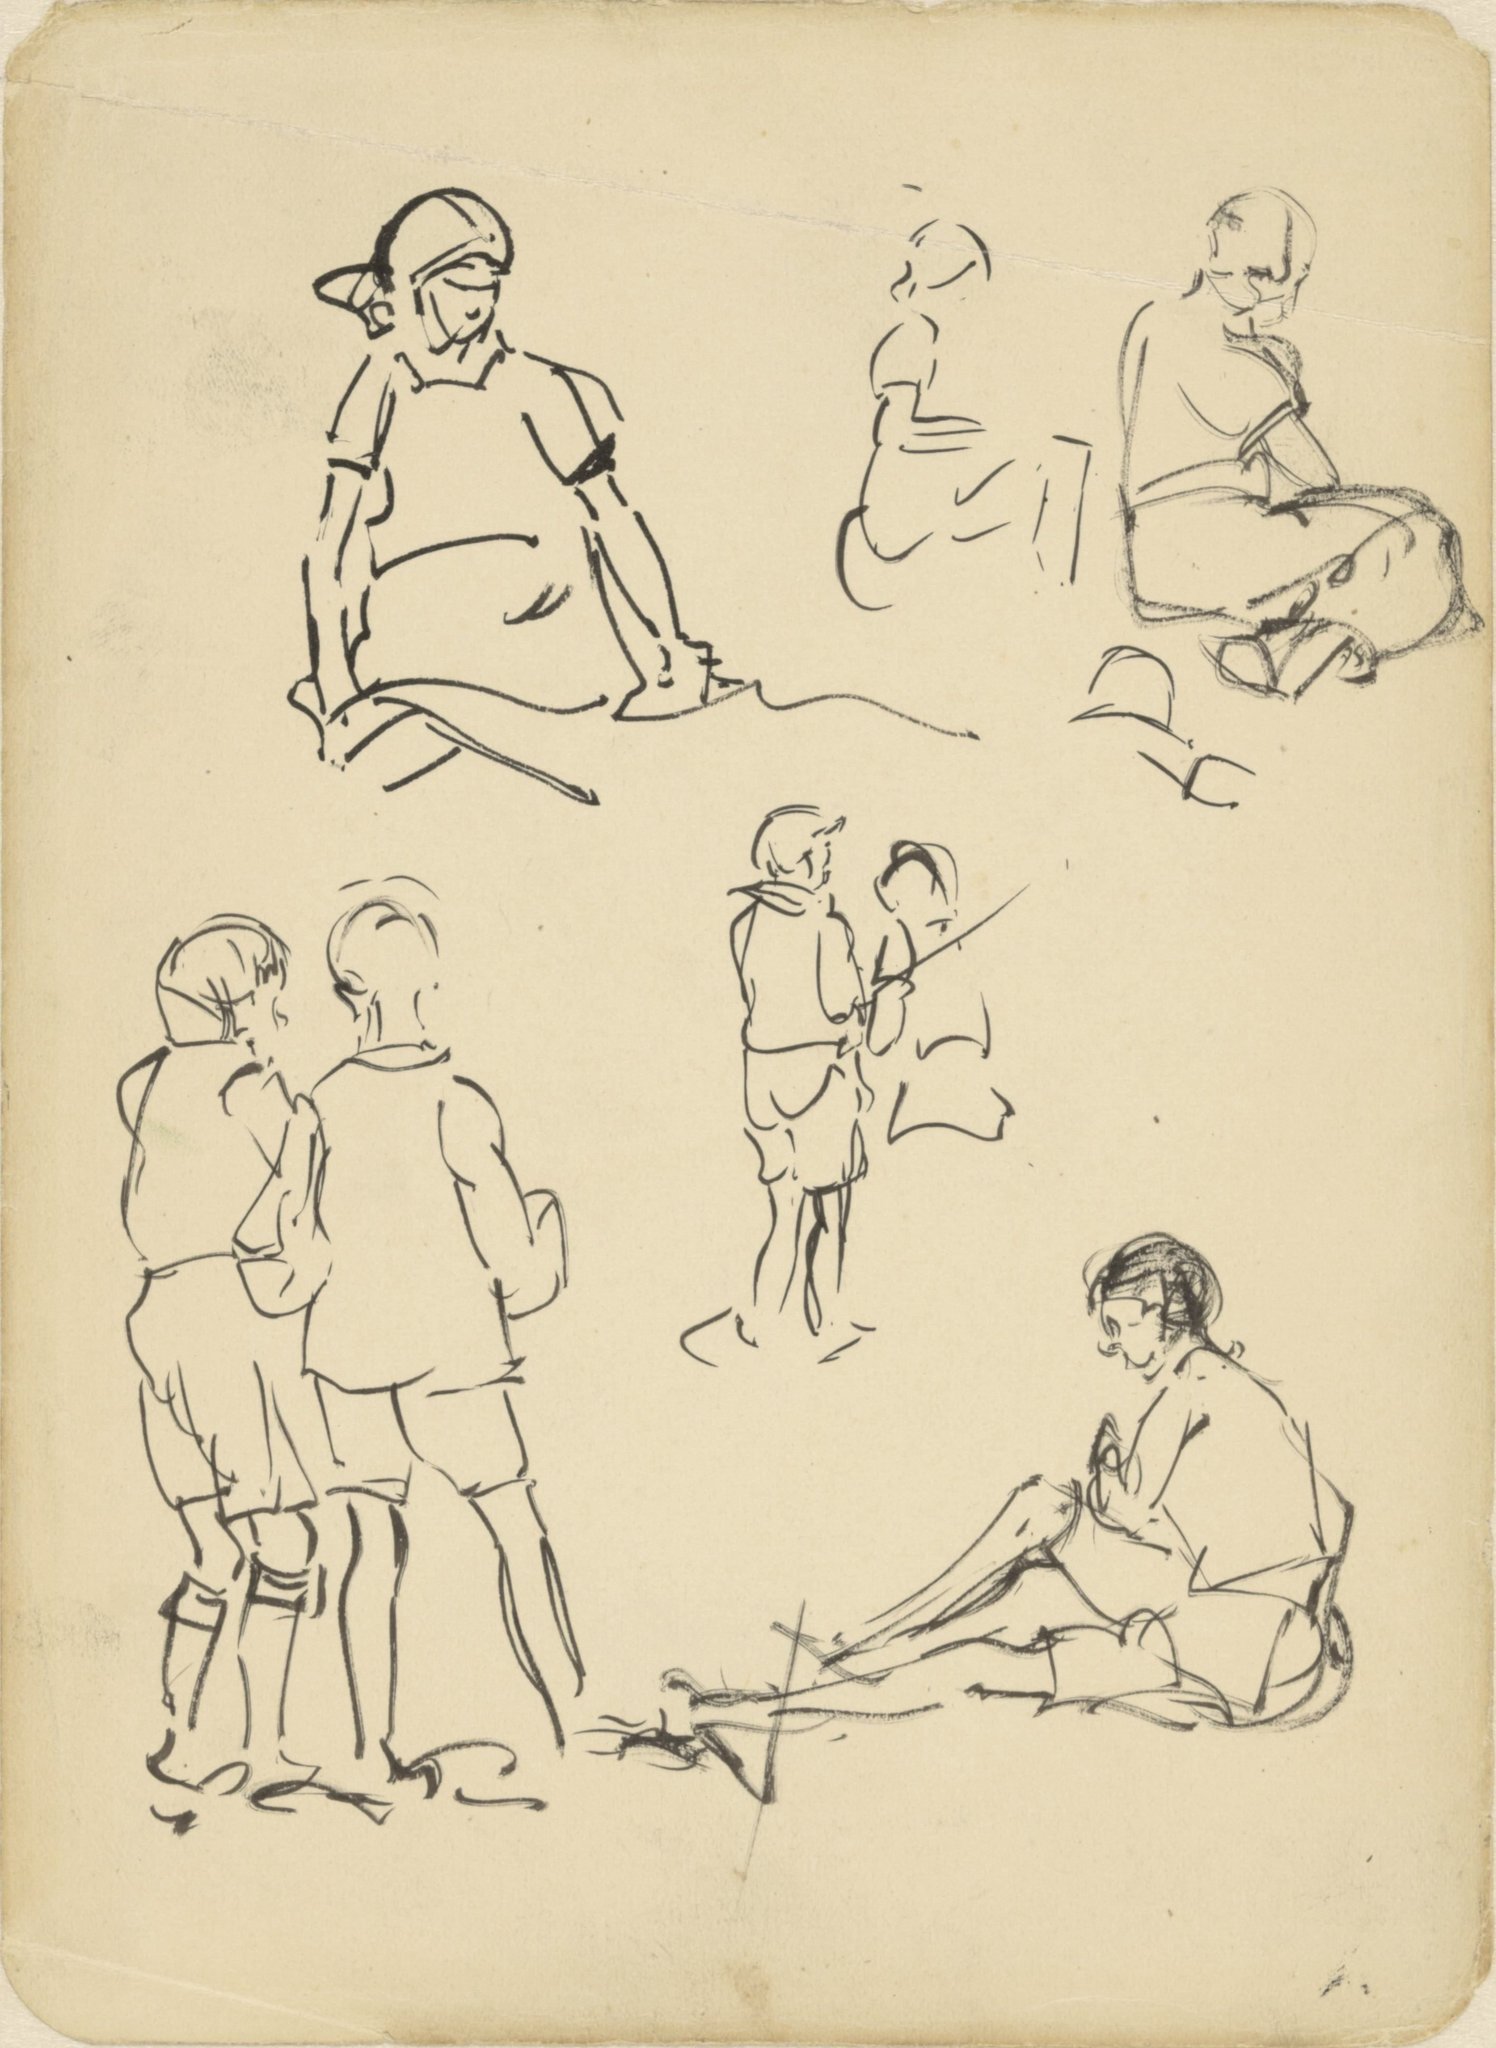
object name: drawing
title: Kinderen en zittende vrouw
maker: dick ket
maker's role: draughtsman, print maker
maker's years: 1902-1940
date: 1912-1940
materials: ink, paper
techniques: pen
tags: sitting figure - aa - female human figure, standing figure (canon, proportions)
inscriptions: collector's mark: Lugt 2228